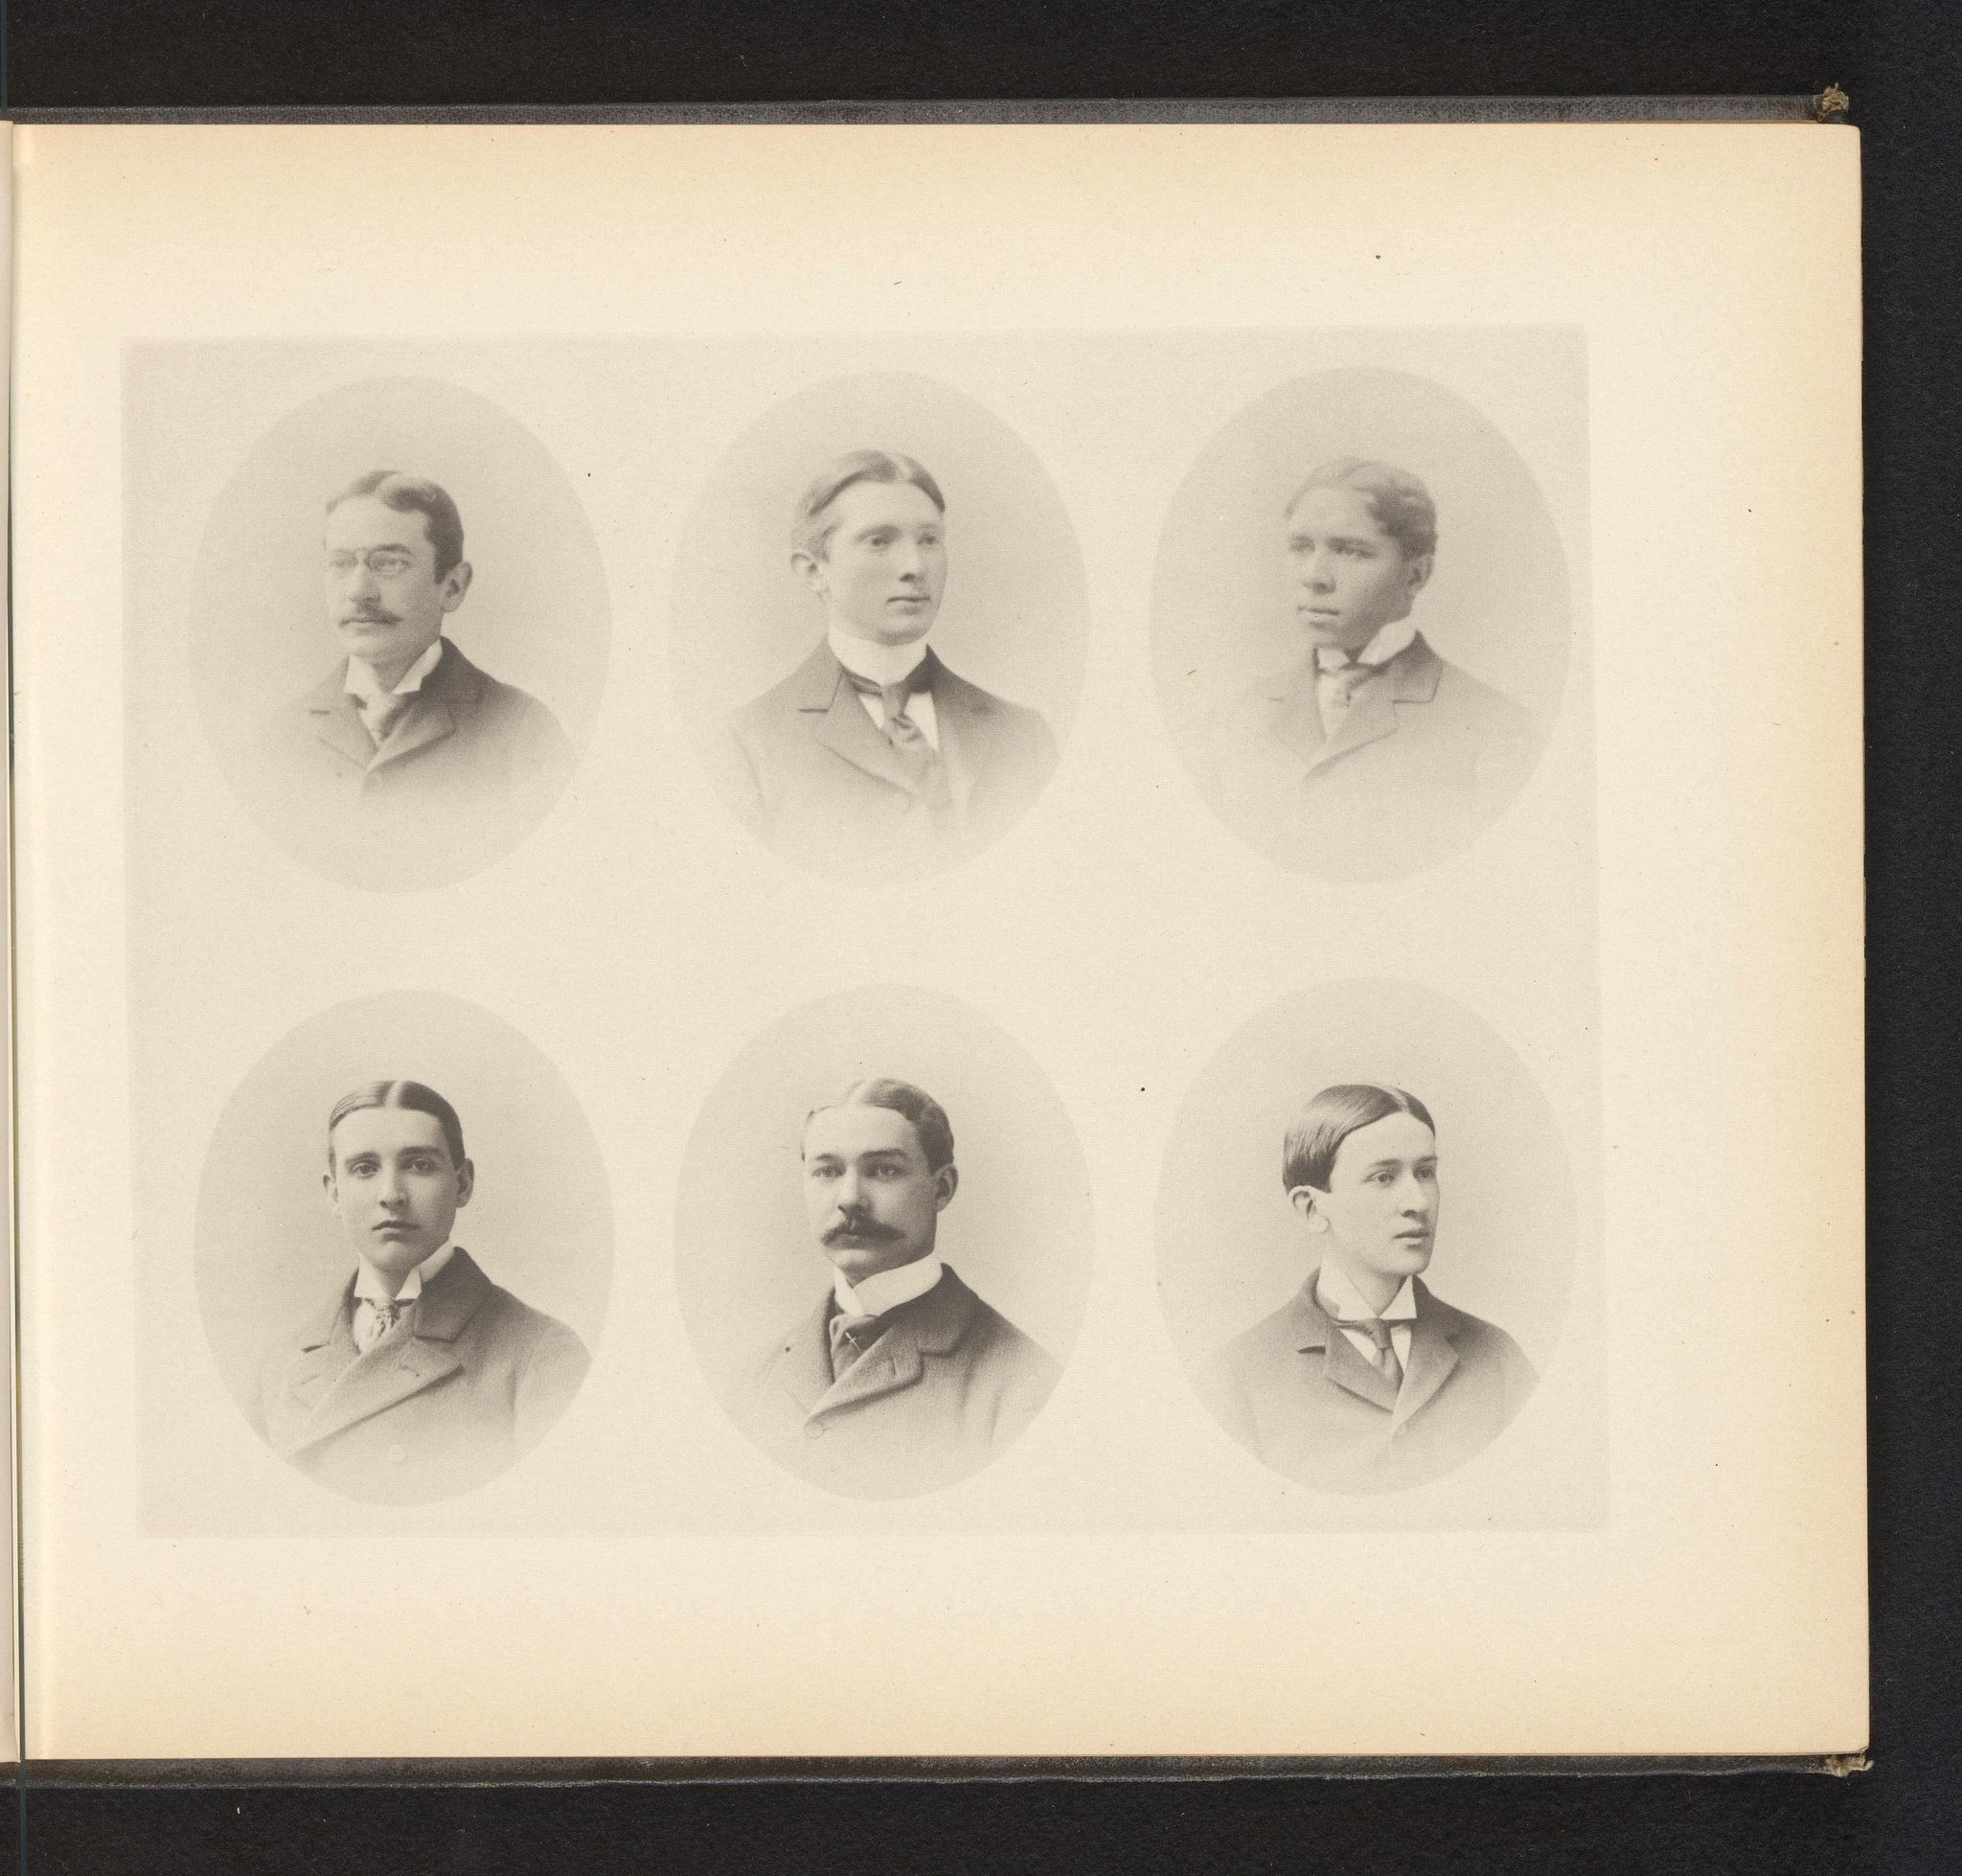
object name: page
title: Zes portretten van afgestudeerde studenten van Yale University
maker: Anonymous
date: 1895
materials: paper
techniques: photograph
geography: new york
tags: student